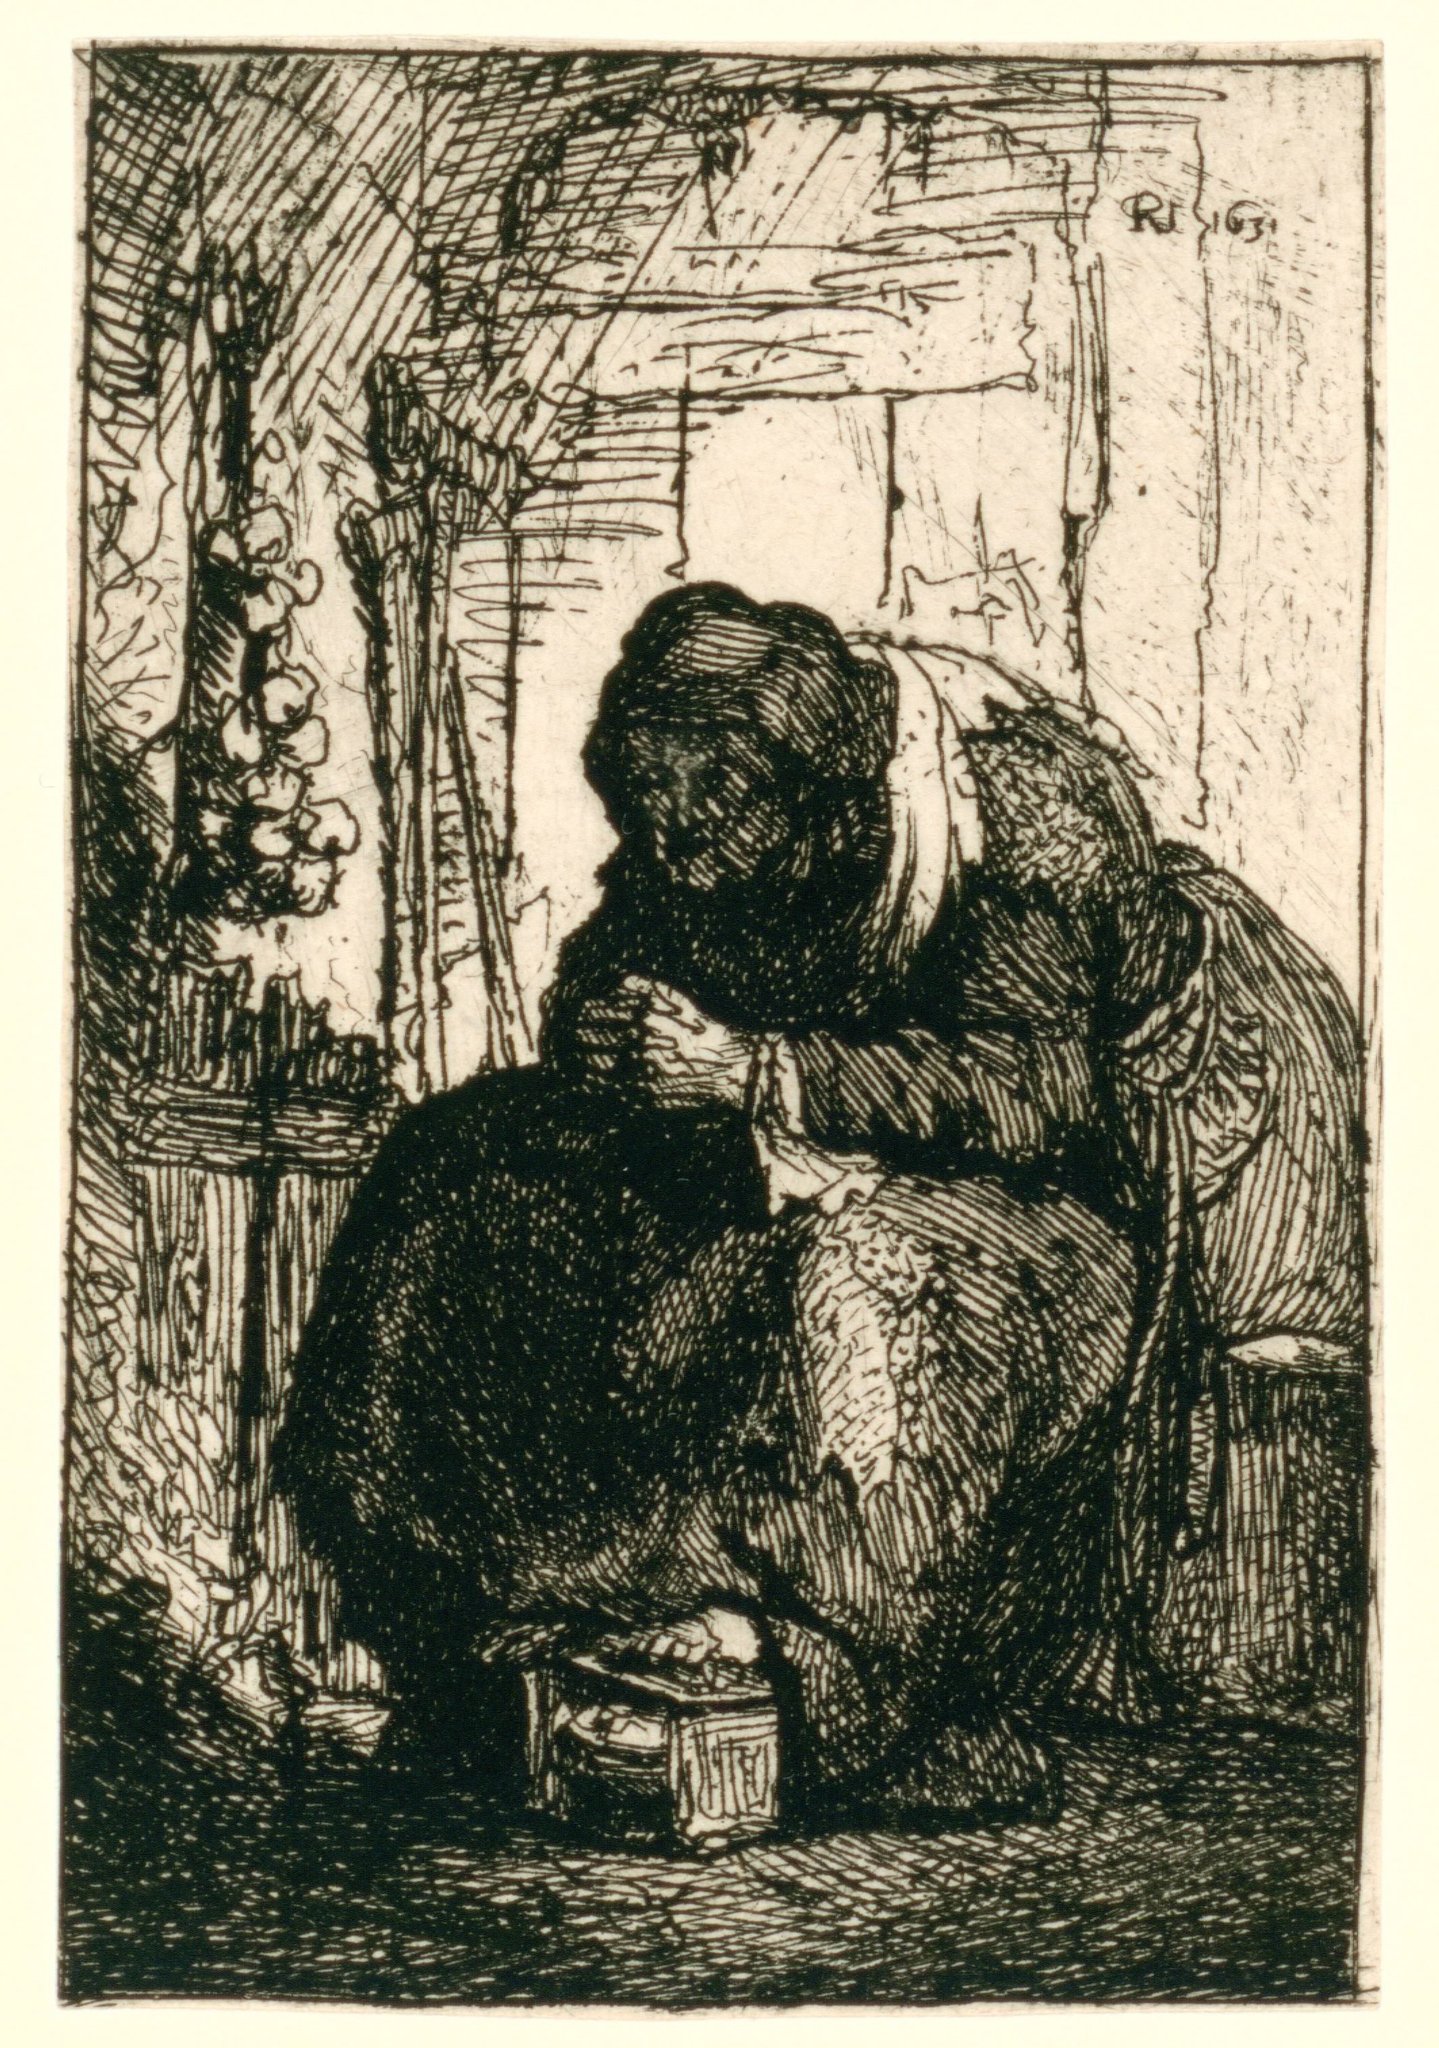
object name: print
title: Old woman seated in a cottage, with a string of onions on the wall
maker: rembrandt van rijn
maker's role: draughtsman, painter, print maker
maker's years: 1606-1669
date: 1629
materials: paper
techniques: etching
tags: old woman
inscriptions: monogram and date: ‘RHL 1631’, collector's mark: Lugt 240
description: De prent is gedateerd 1631, maar niet door Rembrandt.